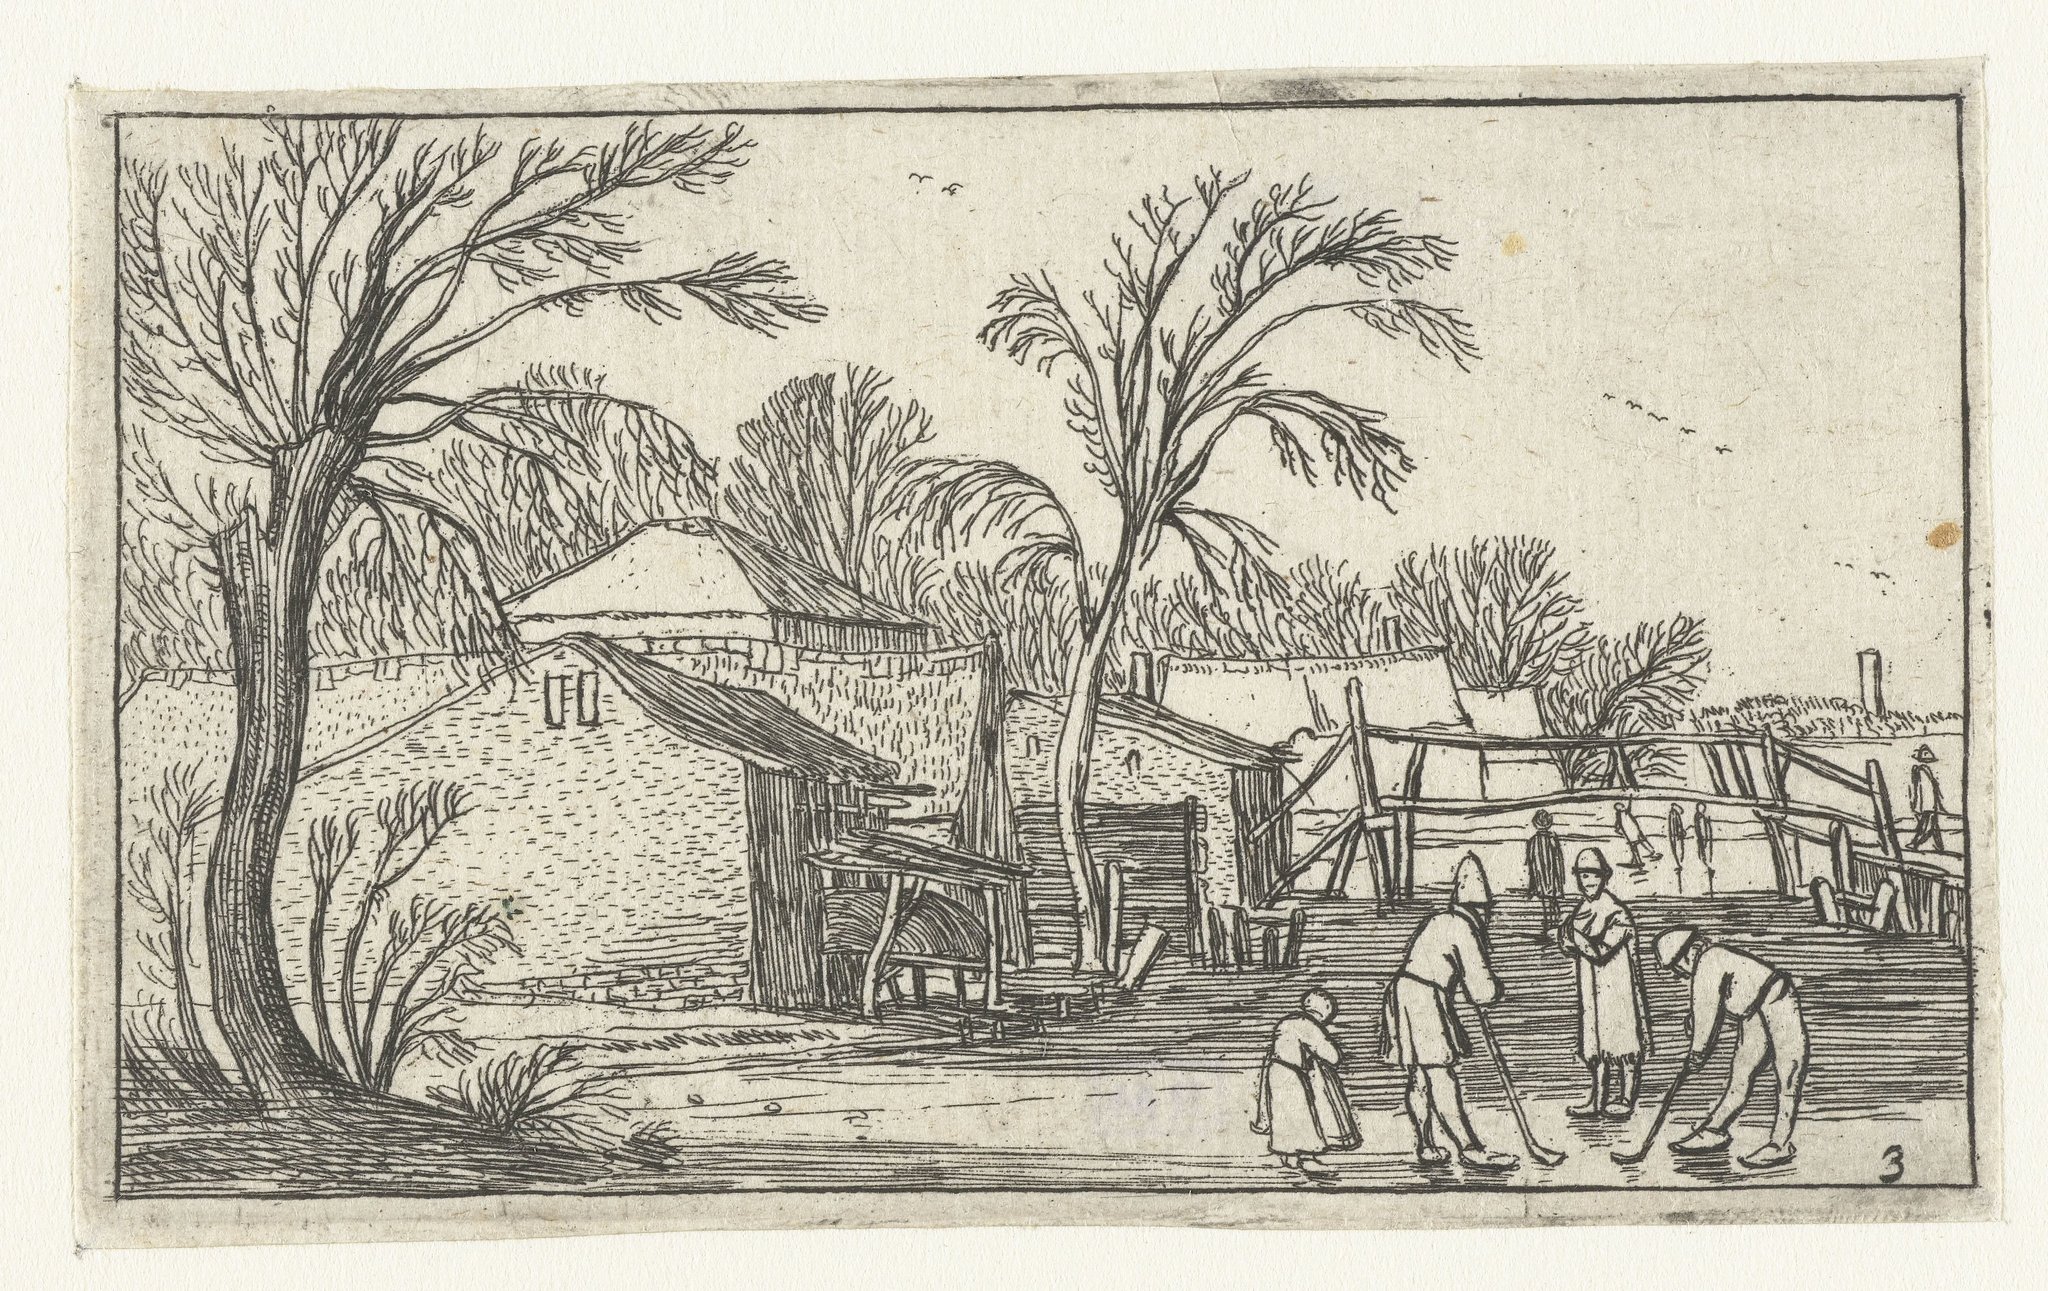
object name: print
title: Landschappen naar Esaias van de Velde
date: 1610-1617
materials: paper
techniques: etching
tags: skates (winter sports), 'kolf' (ball game)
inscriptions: collector's mark: Lugt 2227